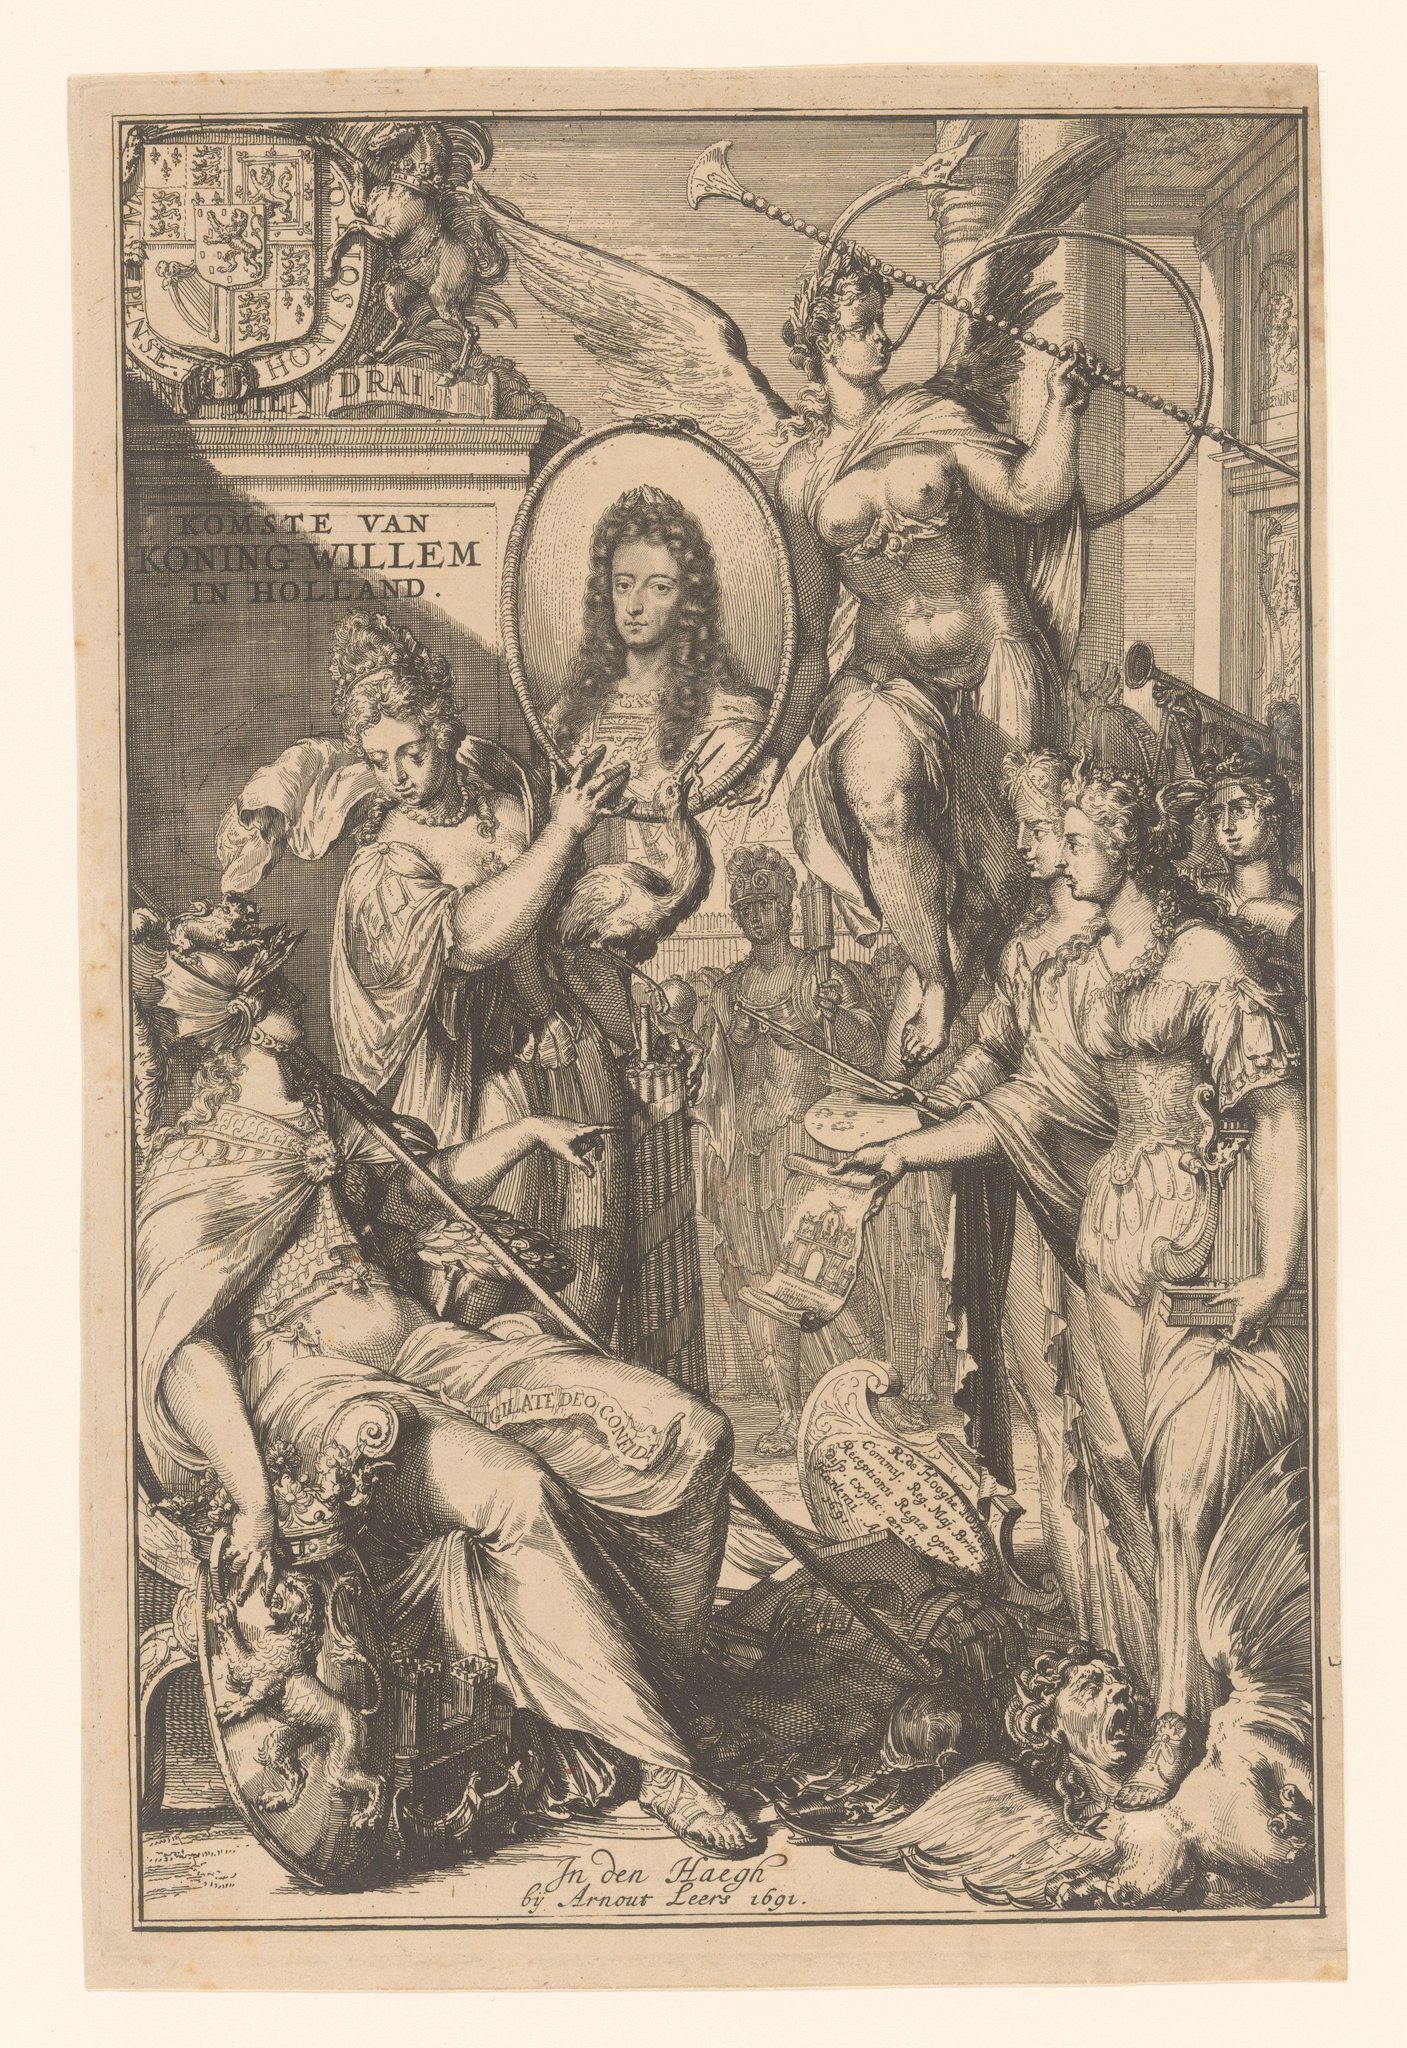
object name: print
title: Komste van Koning Willem in Holland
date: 1691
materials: paper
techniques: etching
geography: northern netherlands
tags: the hague, william iii (prince of orange and king of england, scotland, and ireland), coat of arms (as symbol of the state, etc.), 'pictura', symbolic representations, allegories and emblems ~ painting; 'pittura' (ripa), personifications of countries, nations, states, districts, etc., historical persons, 'architectura', symbolic representations, allegories and emblems ~ architecture; 'architettura' (ripa), fame; 'fama', 'fama buona', 'fama chiara' (ripa)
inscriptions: collector's mark: Lugt 2760, collector's mark: Lugt 2228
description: Prent waarschijnlijk uit: Bidloo, Govert. Komste van zyne majesteit Willem III. Koning van Groot Britanje, enz. in Holland; ofte omstandelyke beschryving van alles, […] vercierd met kopere plaaten. Den Haag: Arnout Leers, 1691.